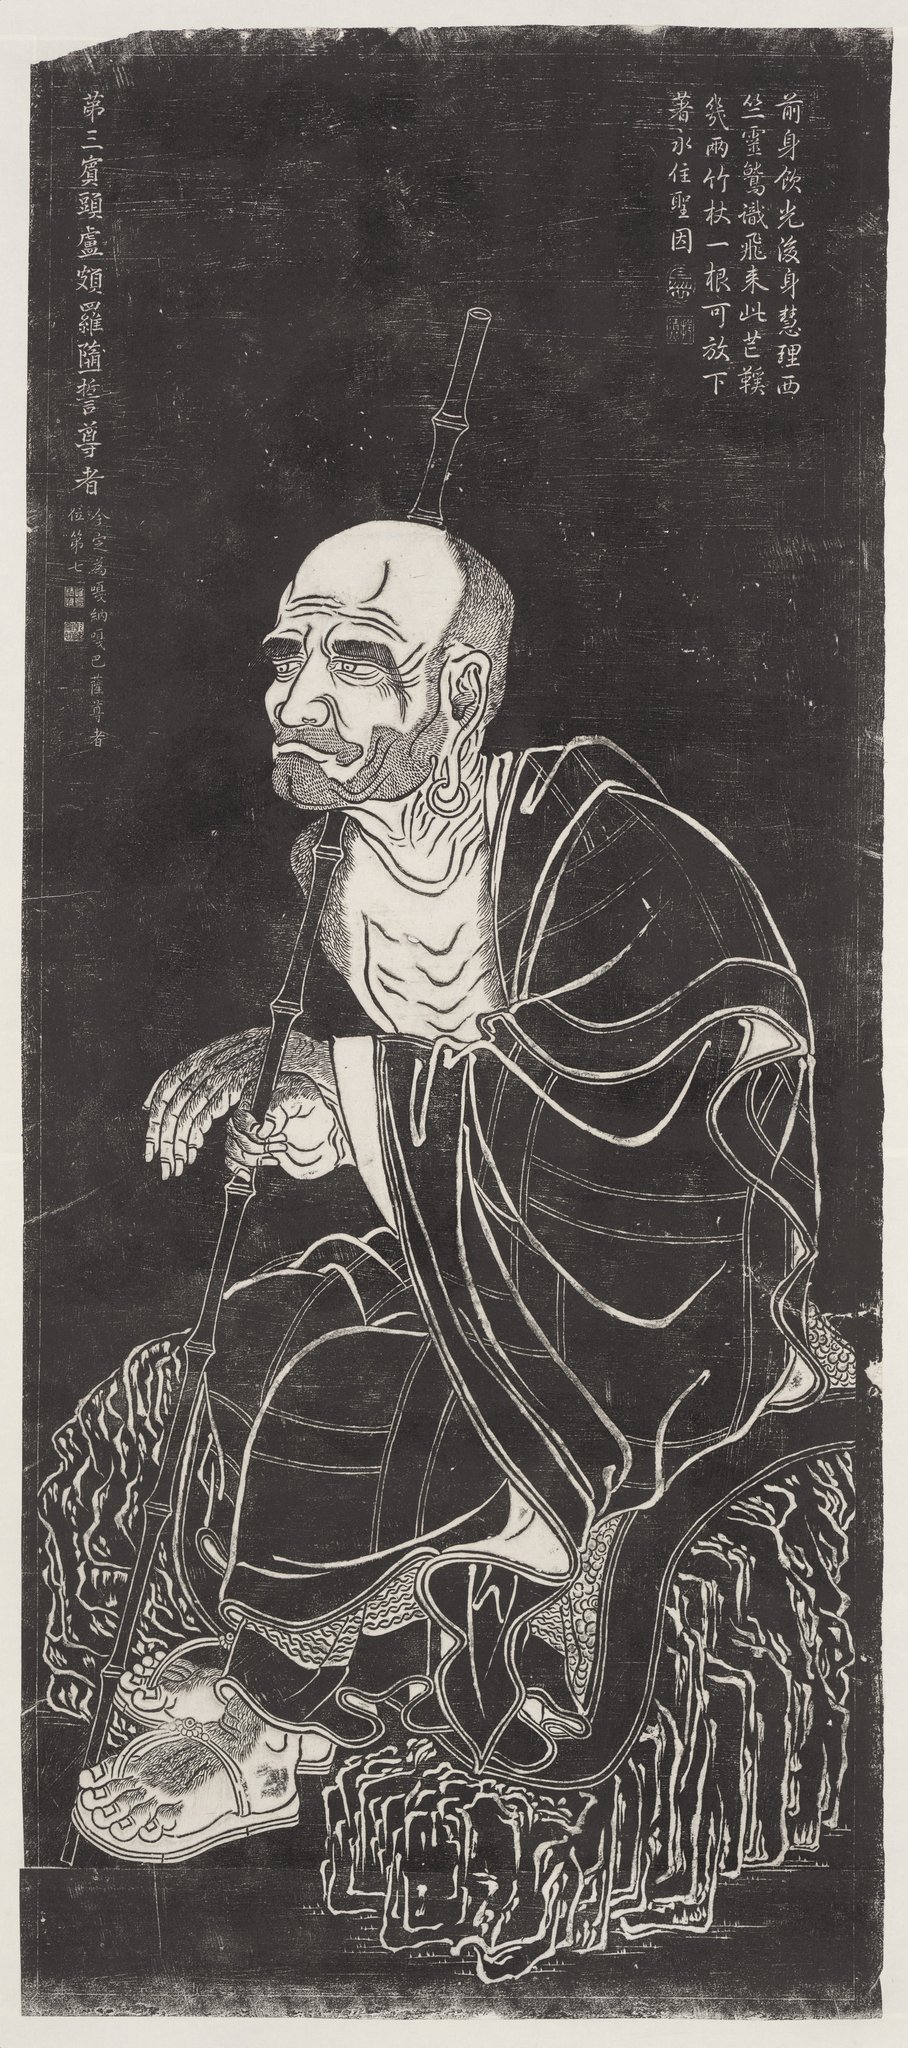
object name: rubbing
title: Luohan, after a set attributed to Guanxiu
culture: chinese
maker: unidentified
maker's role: artist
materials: ink, paper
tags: men